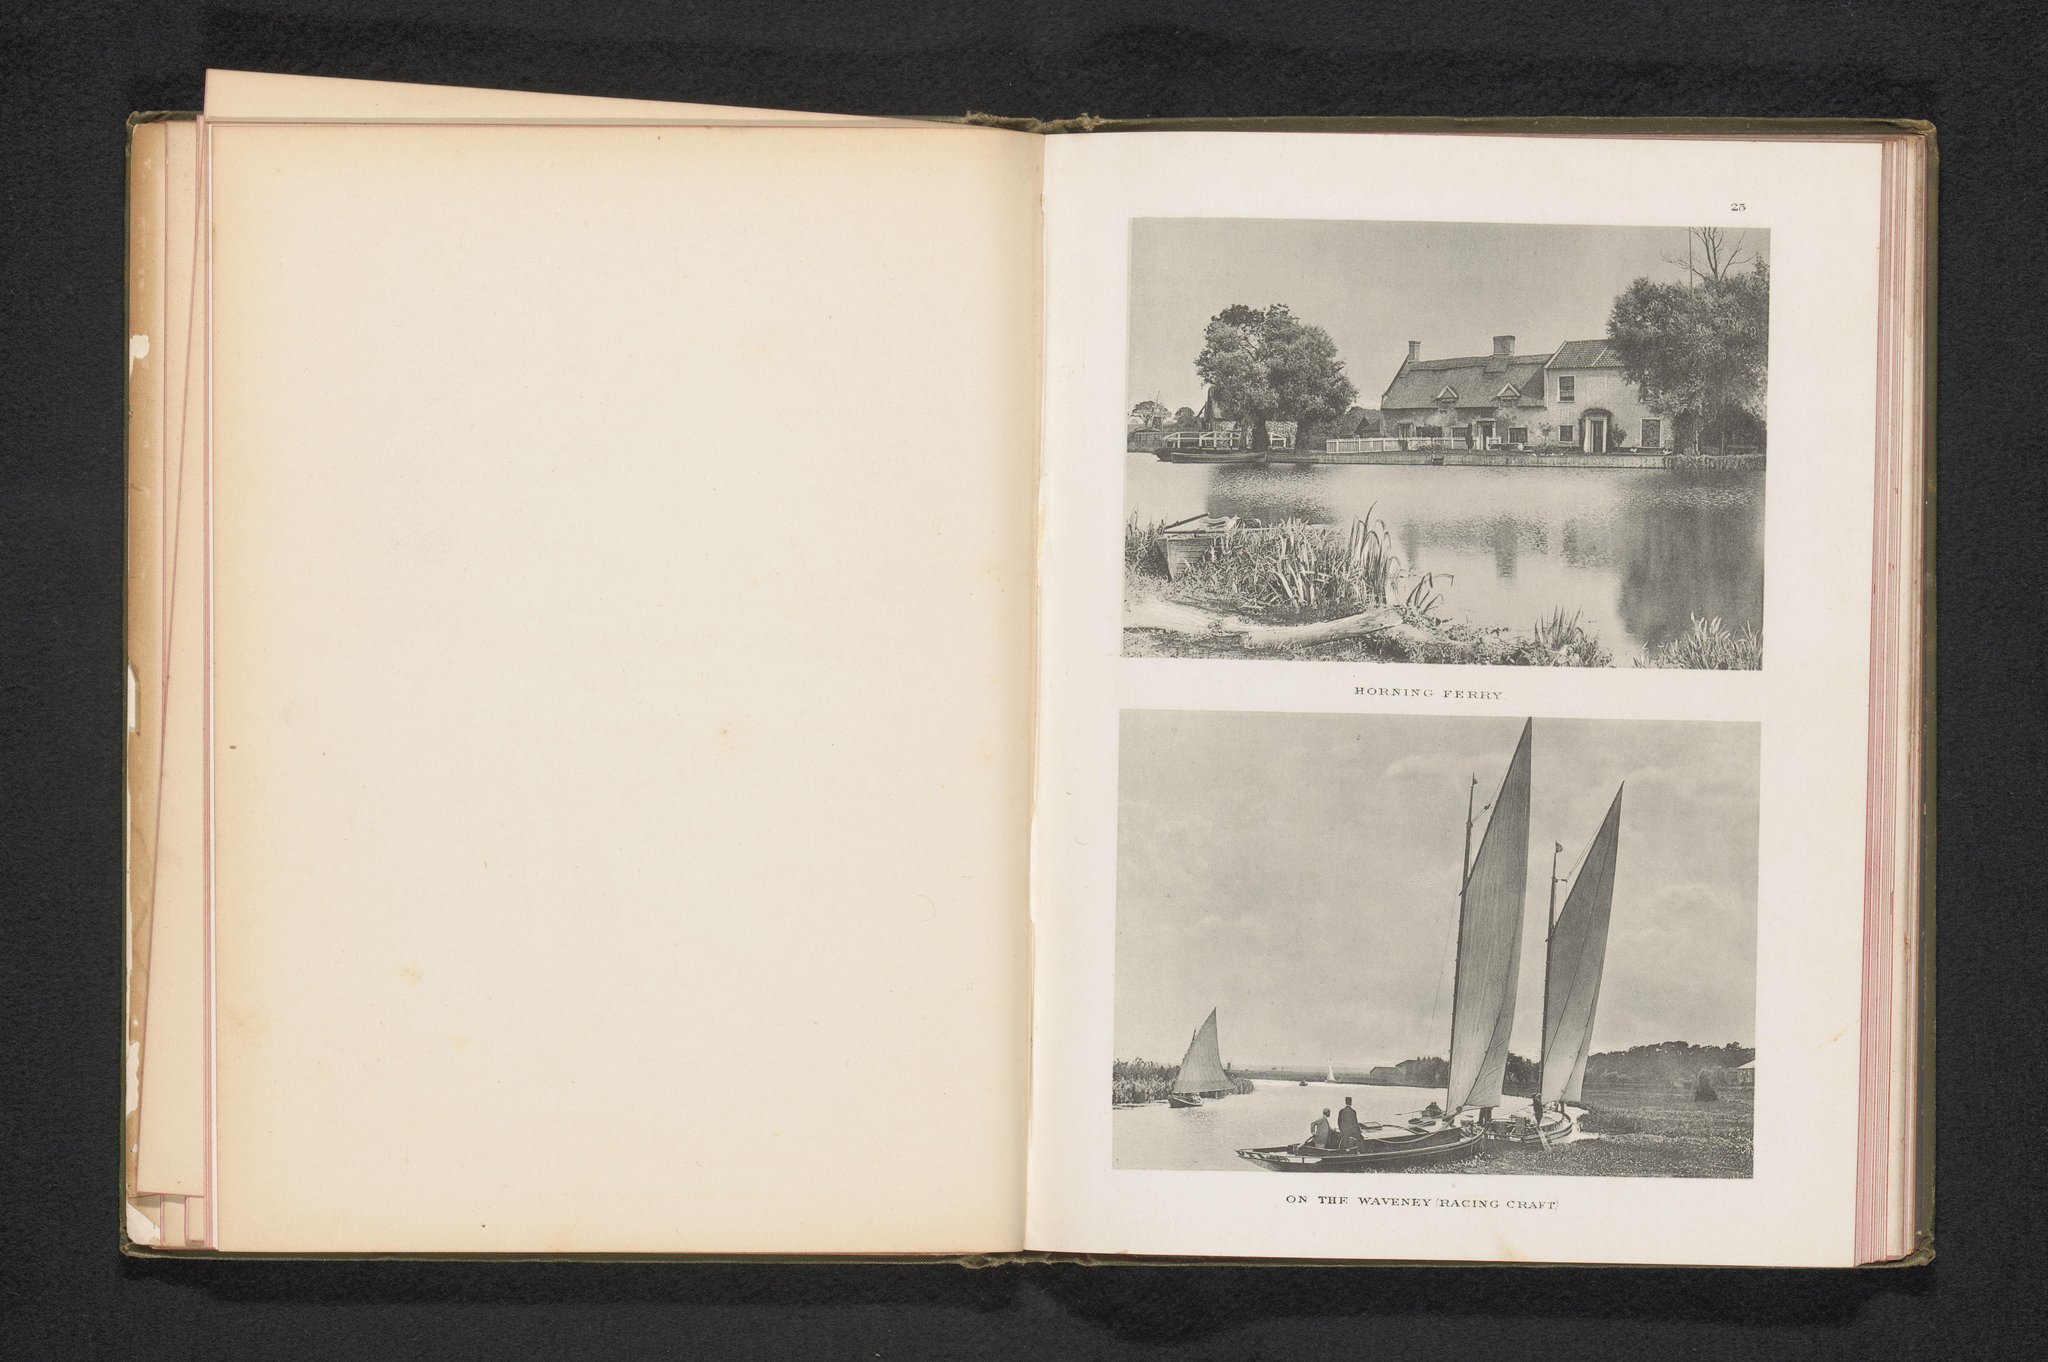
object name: photomechanical print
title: Gezicht op de Waveney met zeilboten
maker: john payne jennings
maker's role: fotograaf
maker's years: 1843-1926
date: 1886-1891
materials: paper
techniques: photograph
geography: surrey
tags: sailing-ship, sailing-boat, river, landscapes with waters, waterscapes, seascapes (in the temperate zone)